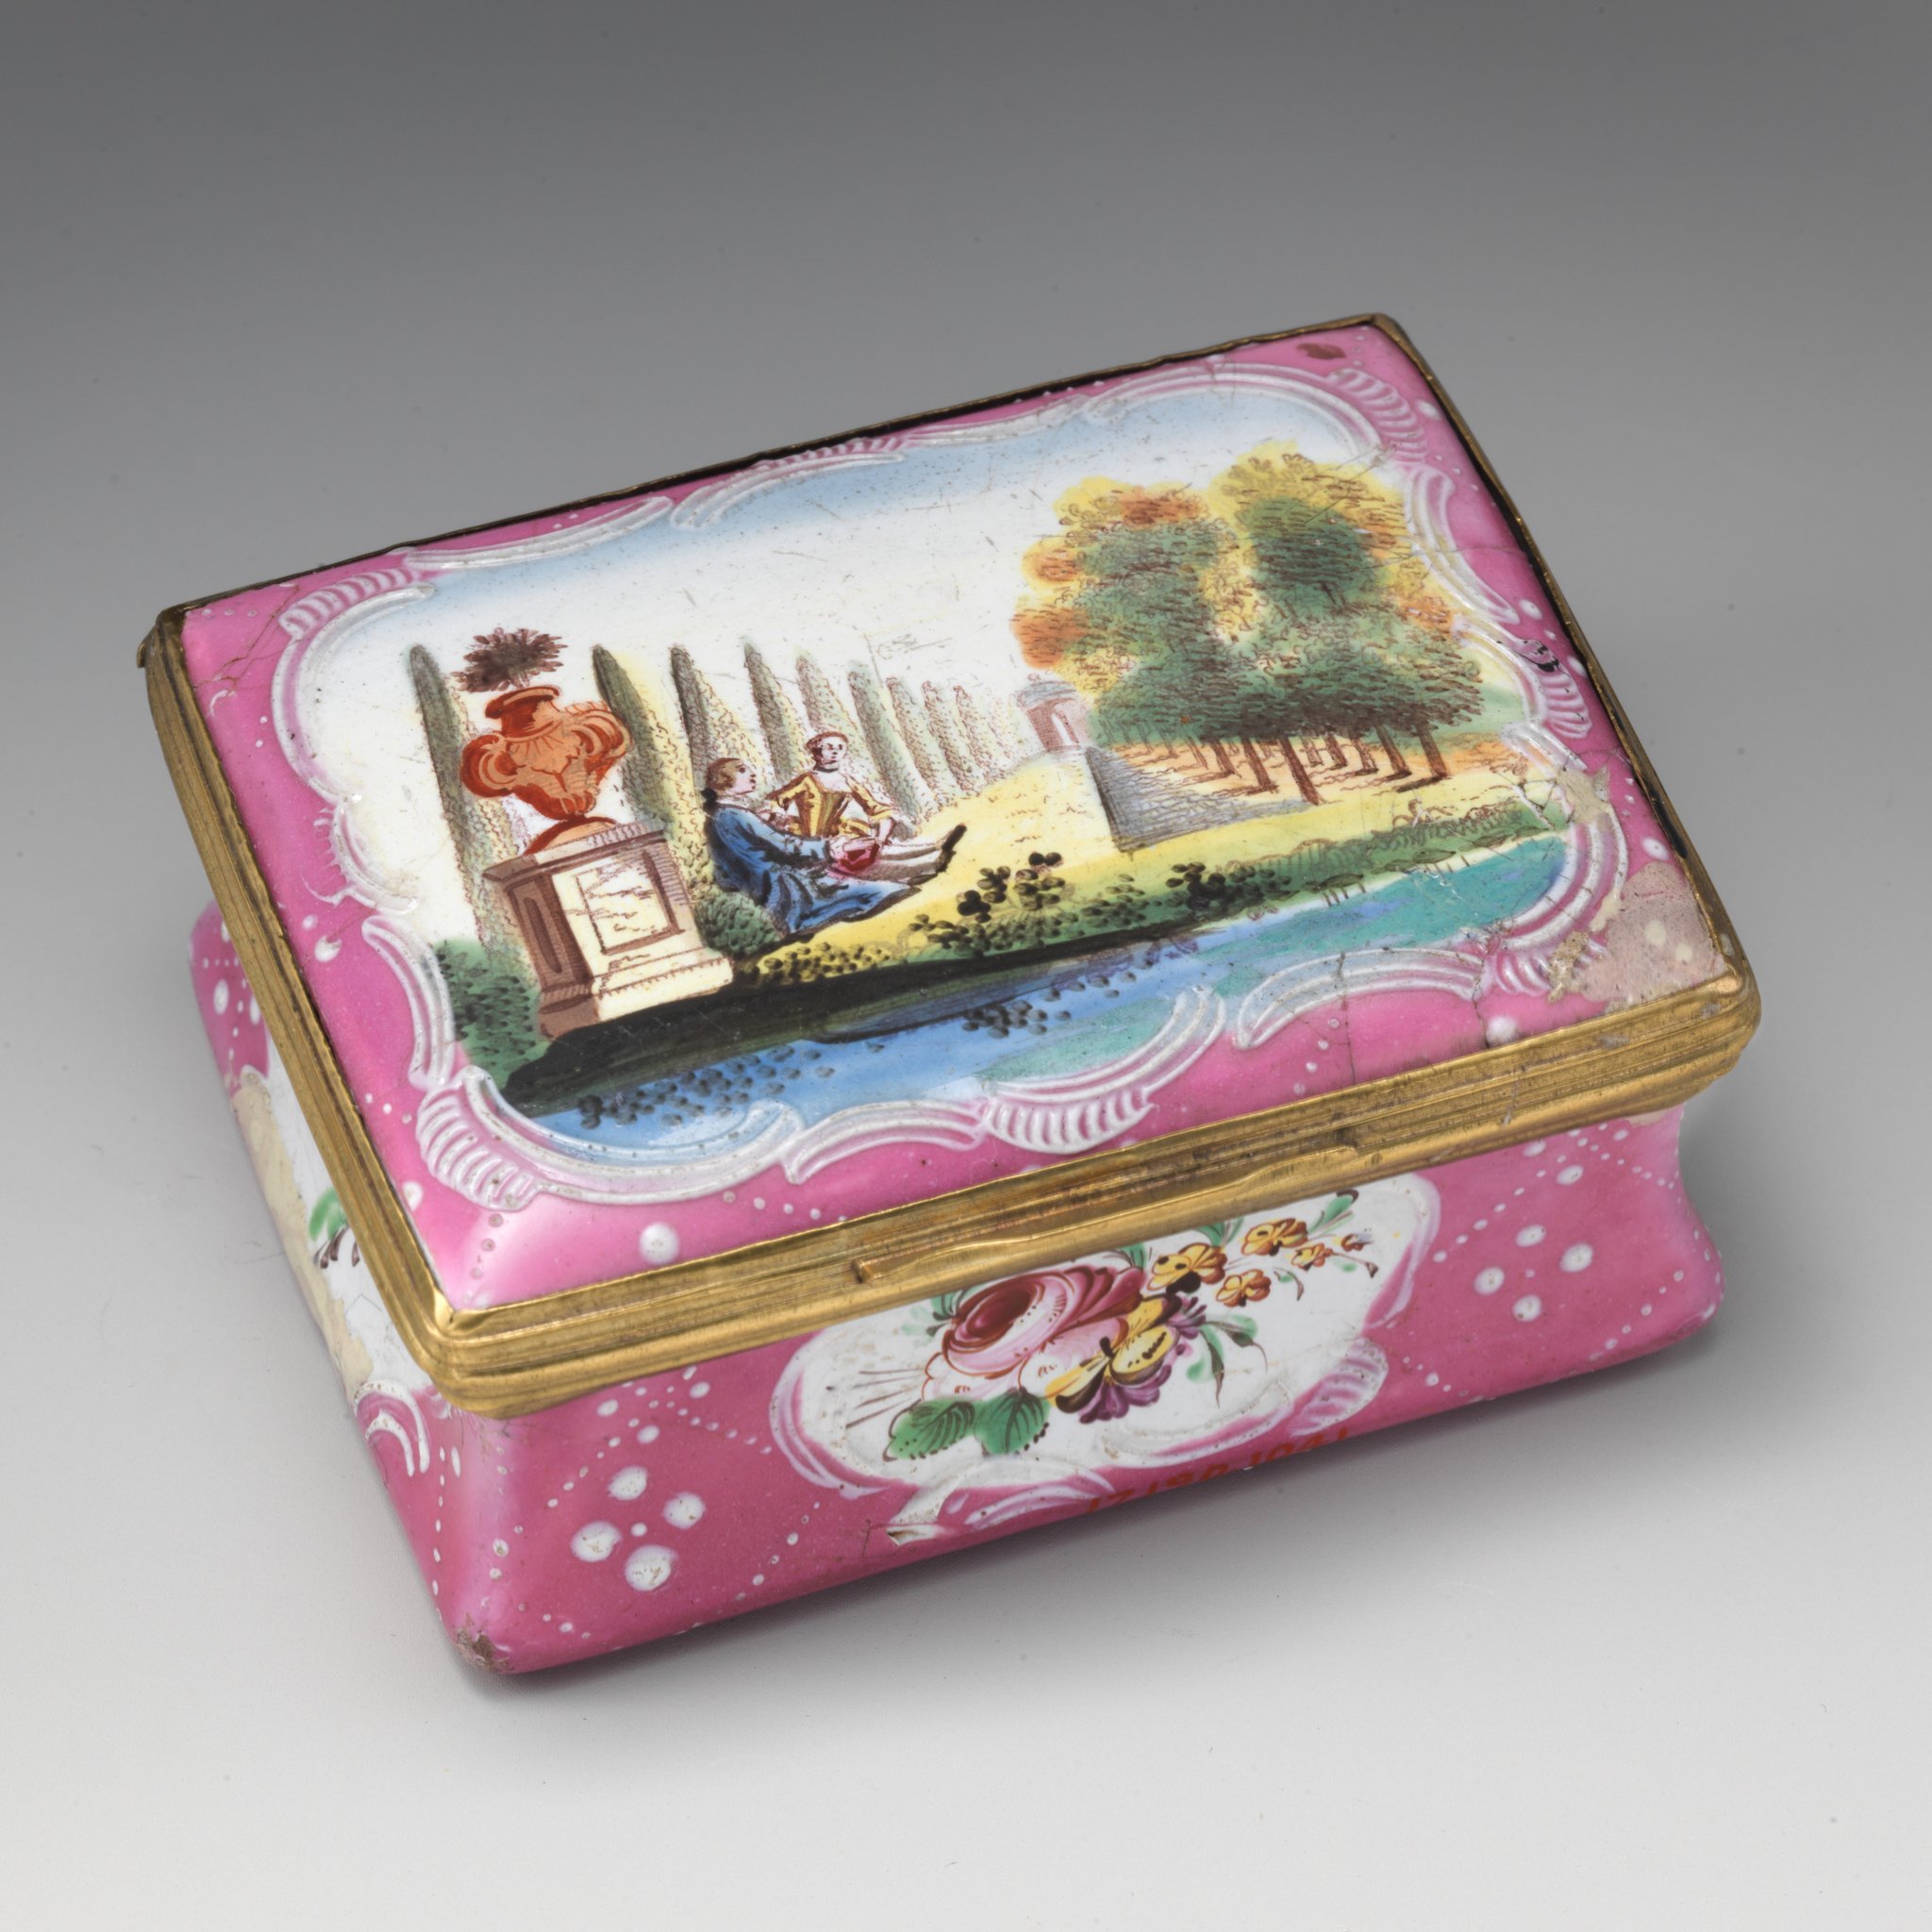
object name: snuffbox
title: Snuffbox with garden scene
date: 1765-1770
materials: copper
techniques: enamel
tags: human figures,flowers,trees